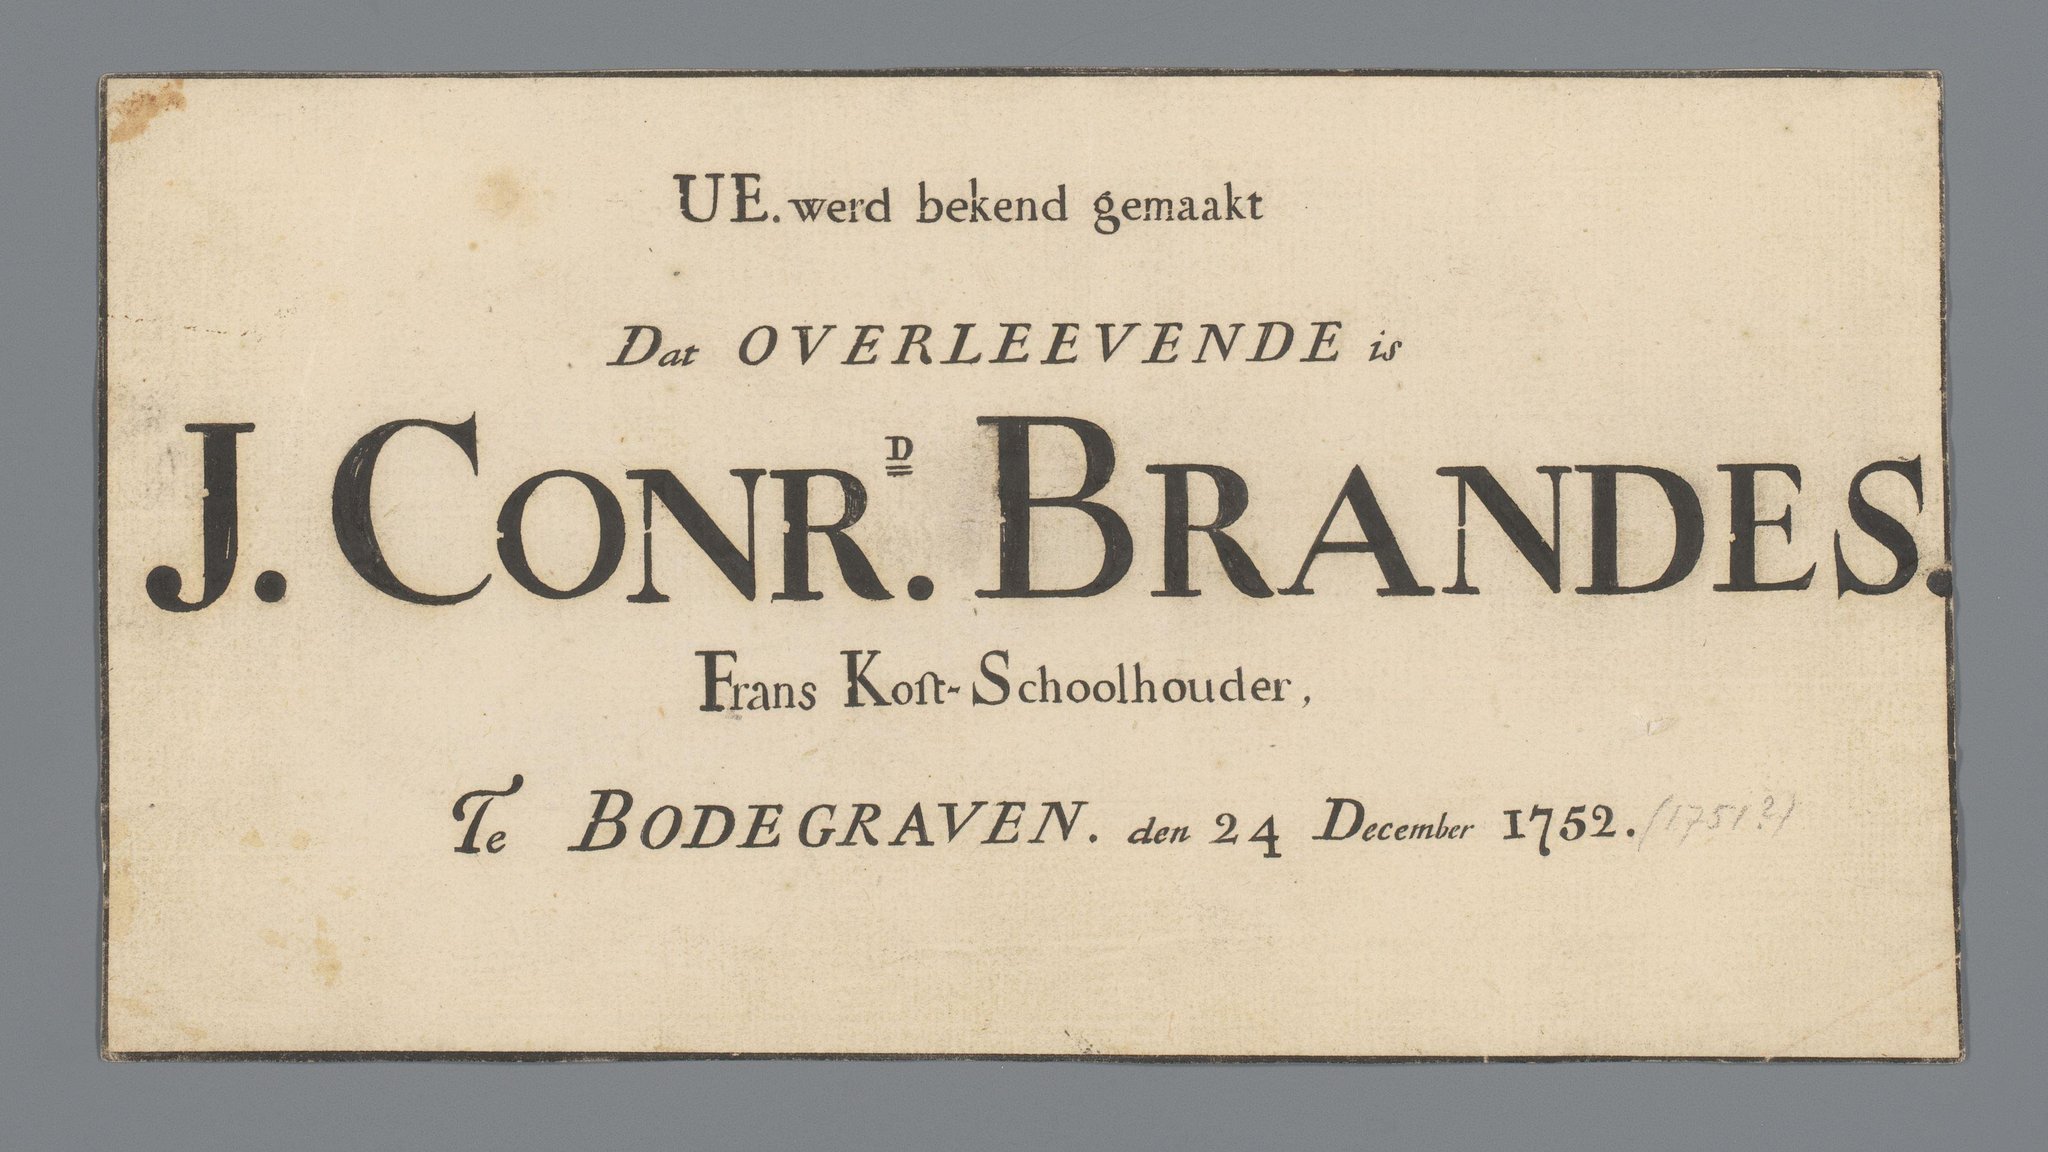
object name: document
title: Bescheiden van Jan Brandes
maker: jan brandes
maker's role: draughtsman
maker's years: 1743-1808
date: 1778-1785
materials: paper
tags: bodegraven, draughtsman, jan brandes